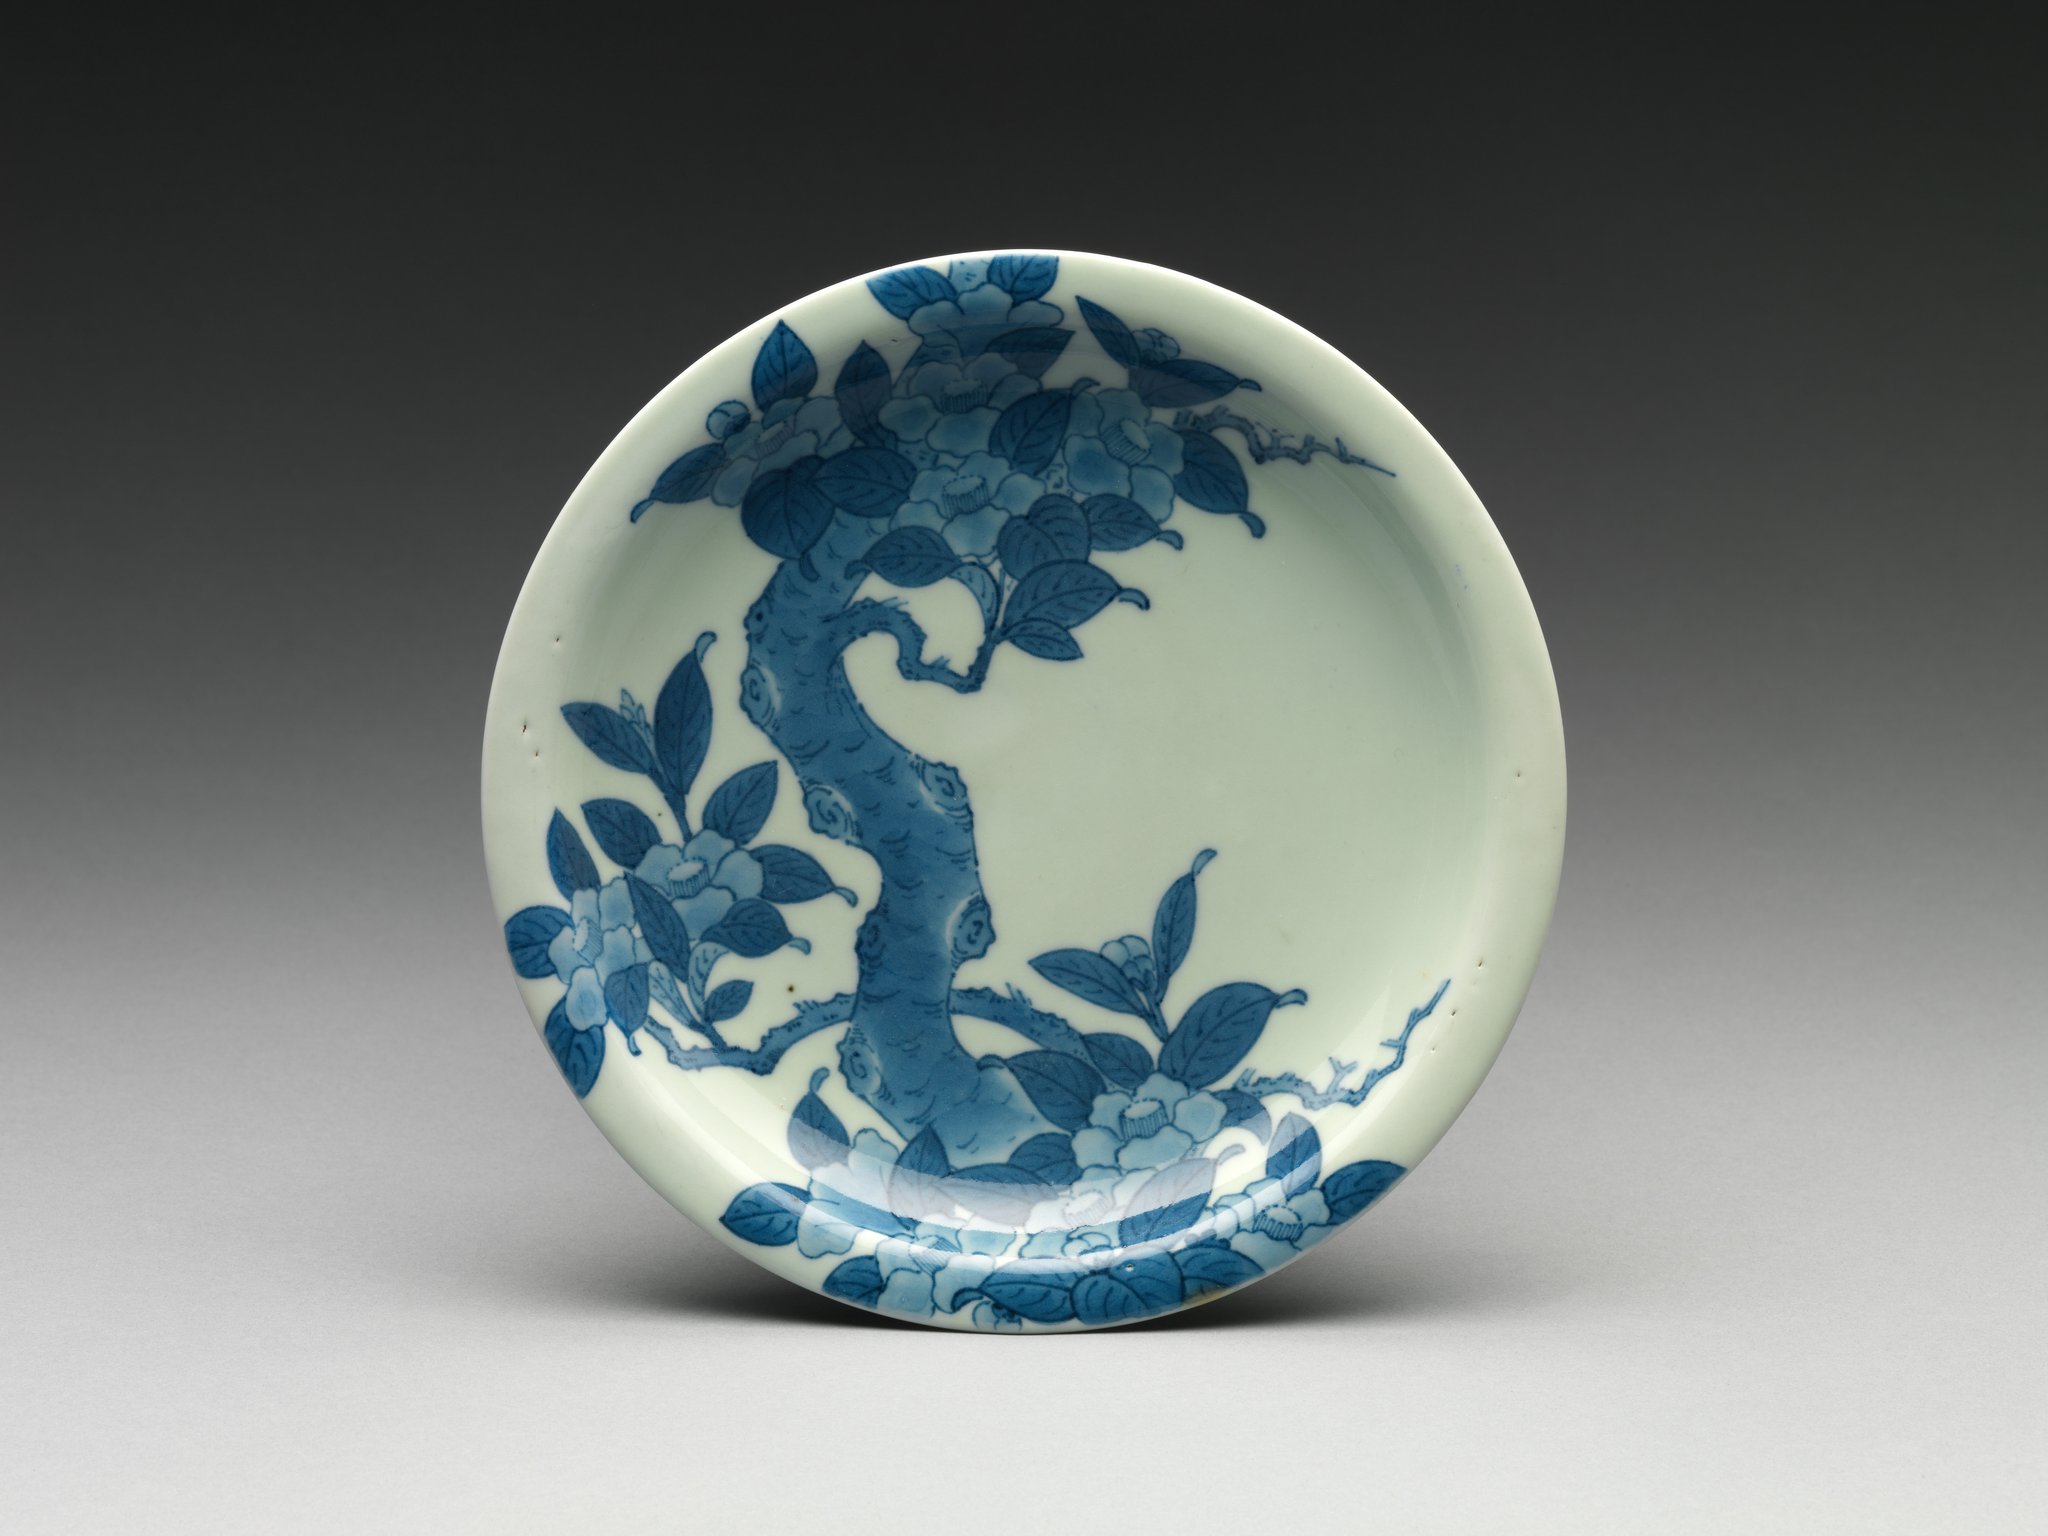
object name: dish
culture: japanese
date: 1701-1733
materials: porcelain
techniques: underglaze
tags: flowers,leaves